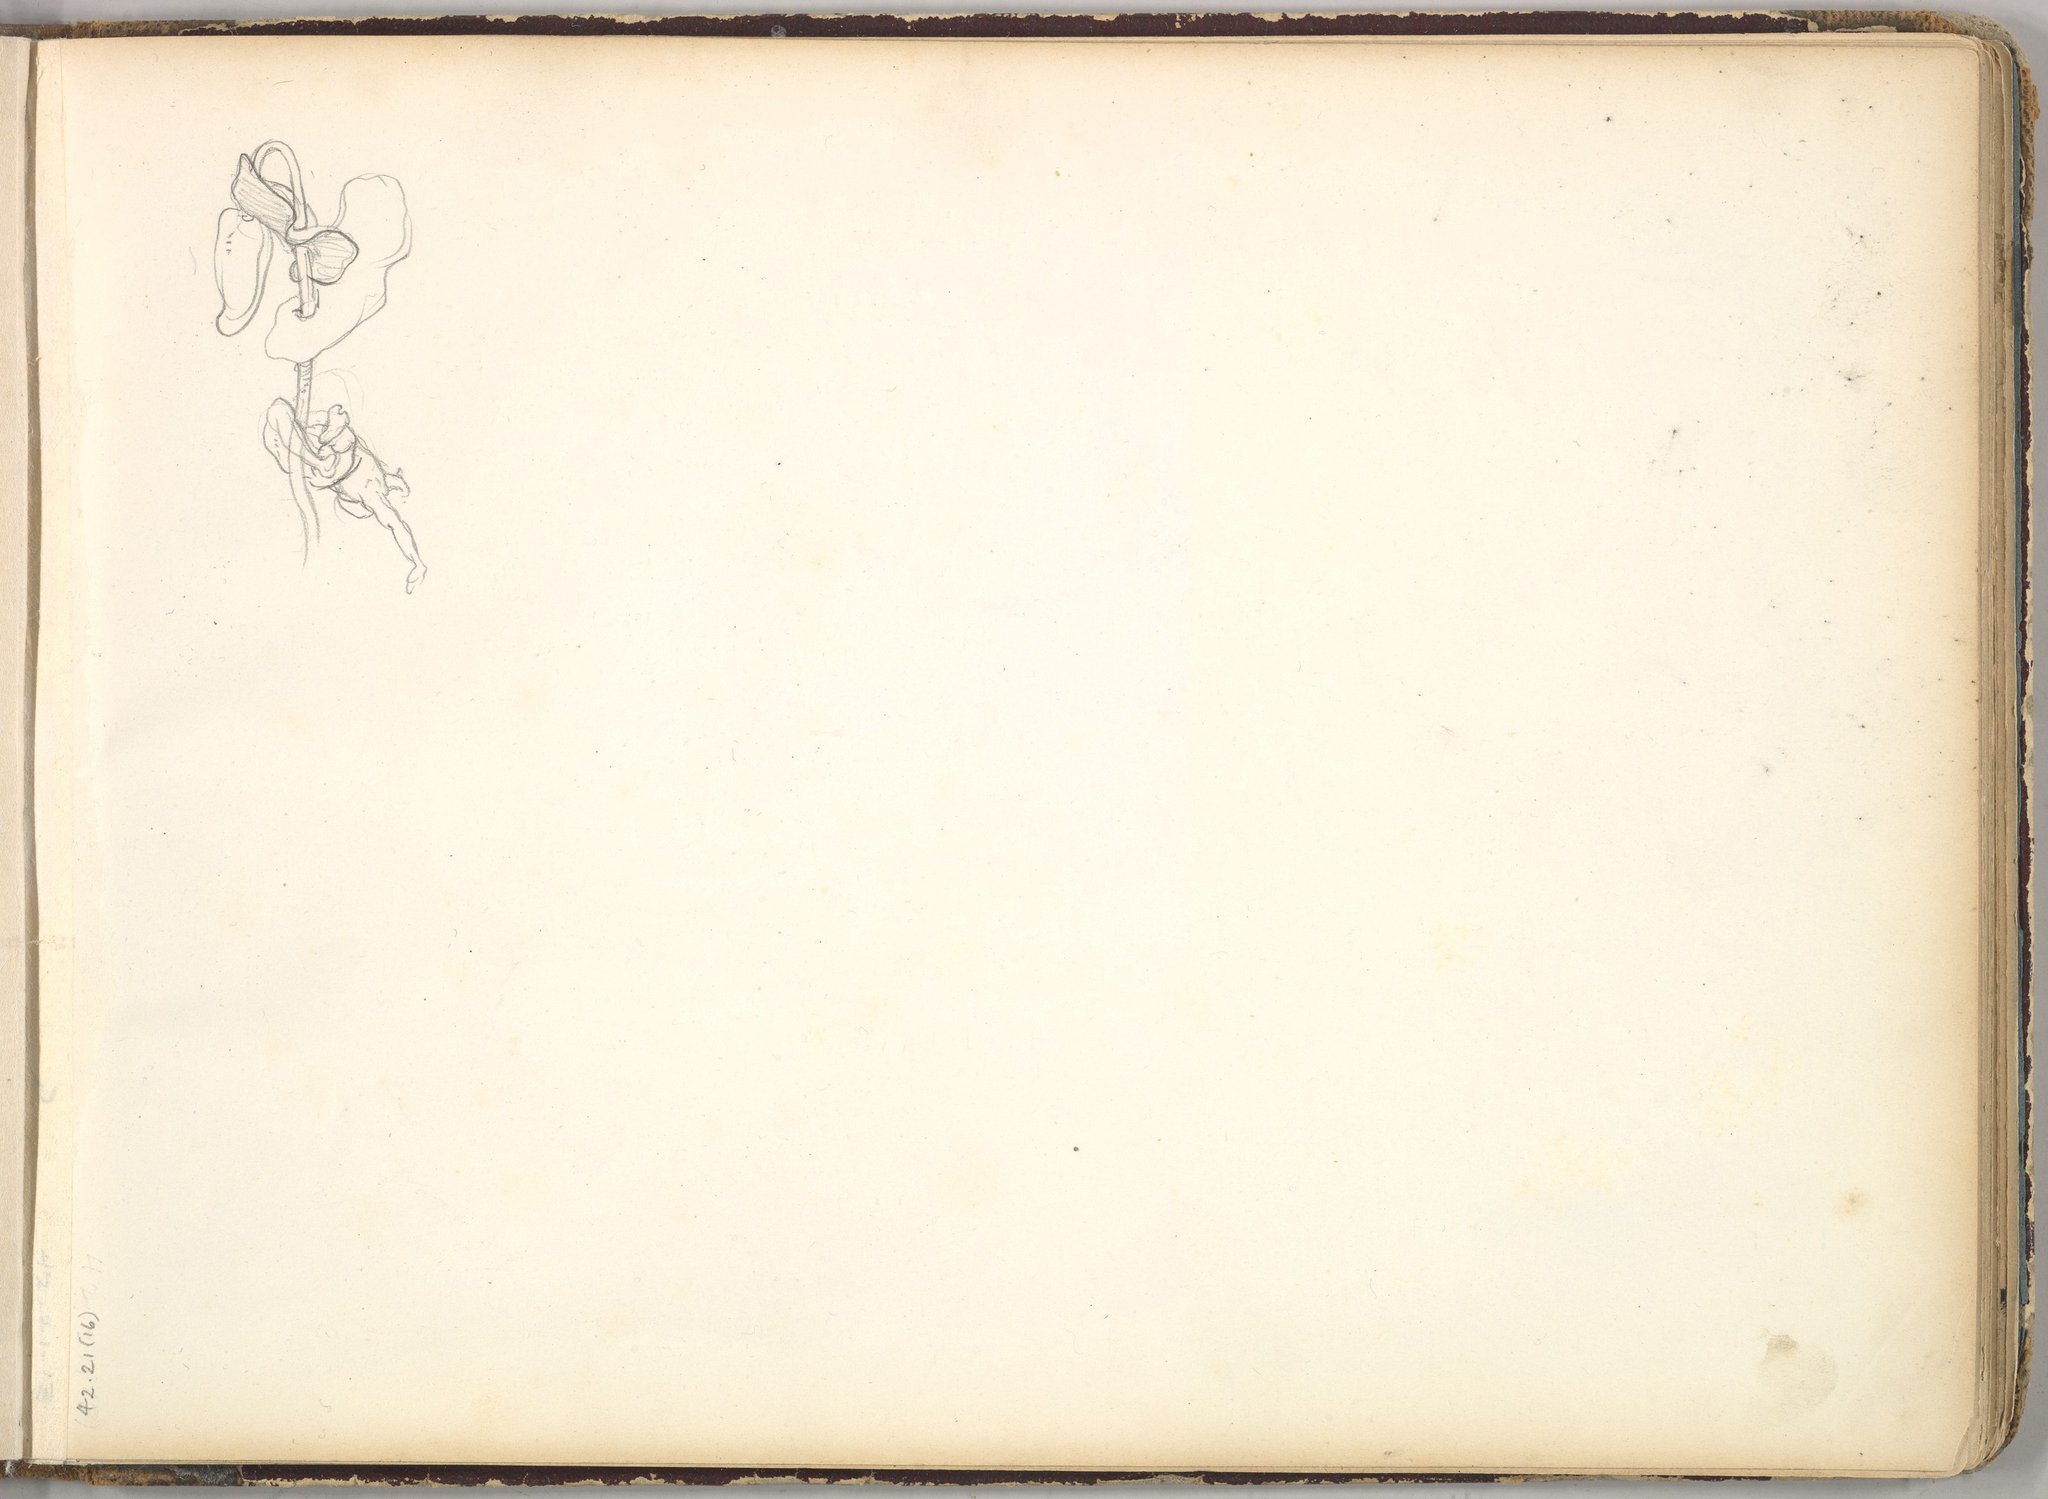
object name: drawing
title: A Flower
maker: frederic, lord leighton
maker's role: artist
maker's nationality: british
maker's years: 1830-1896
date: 1849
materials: graphite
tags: flowers